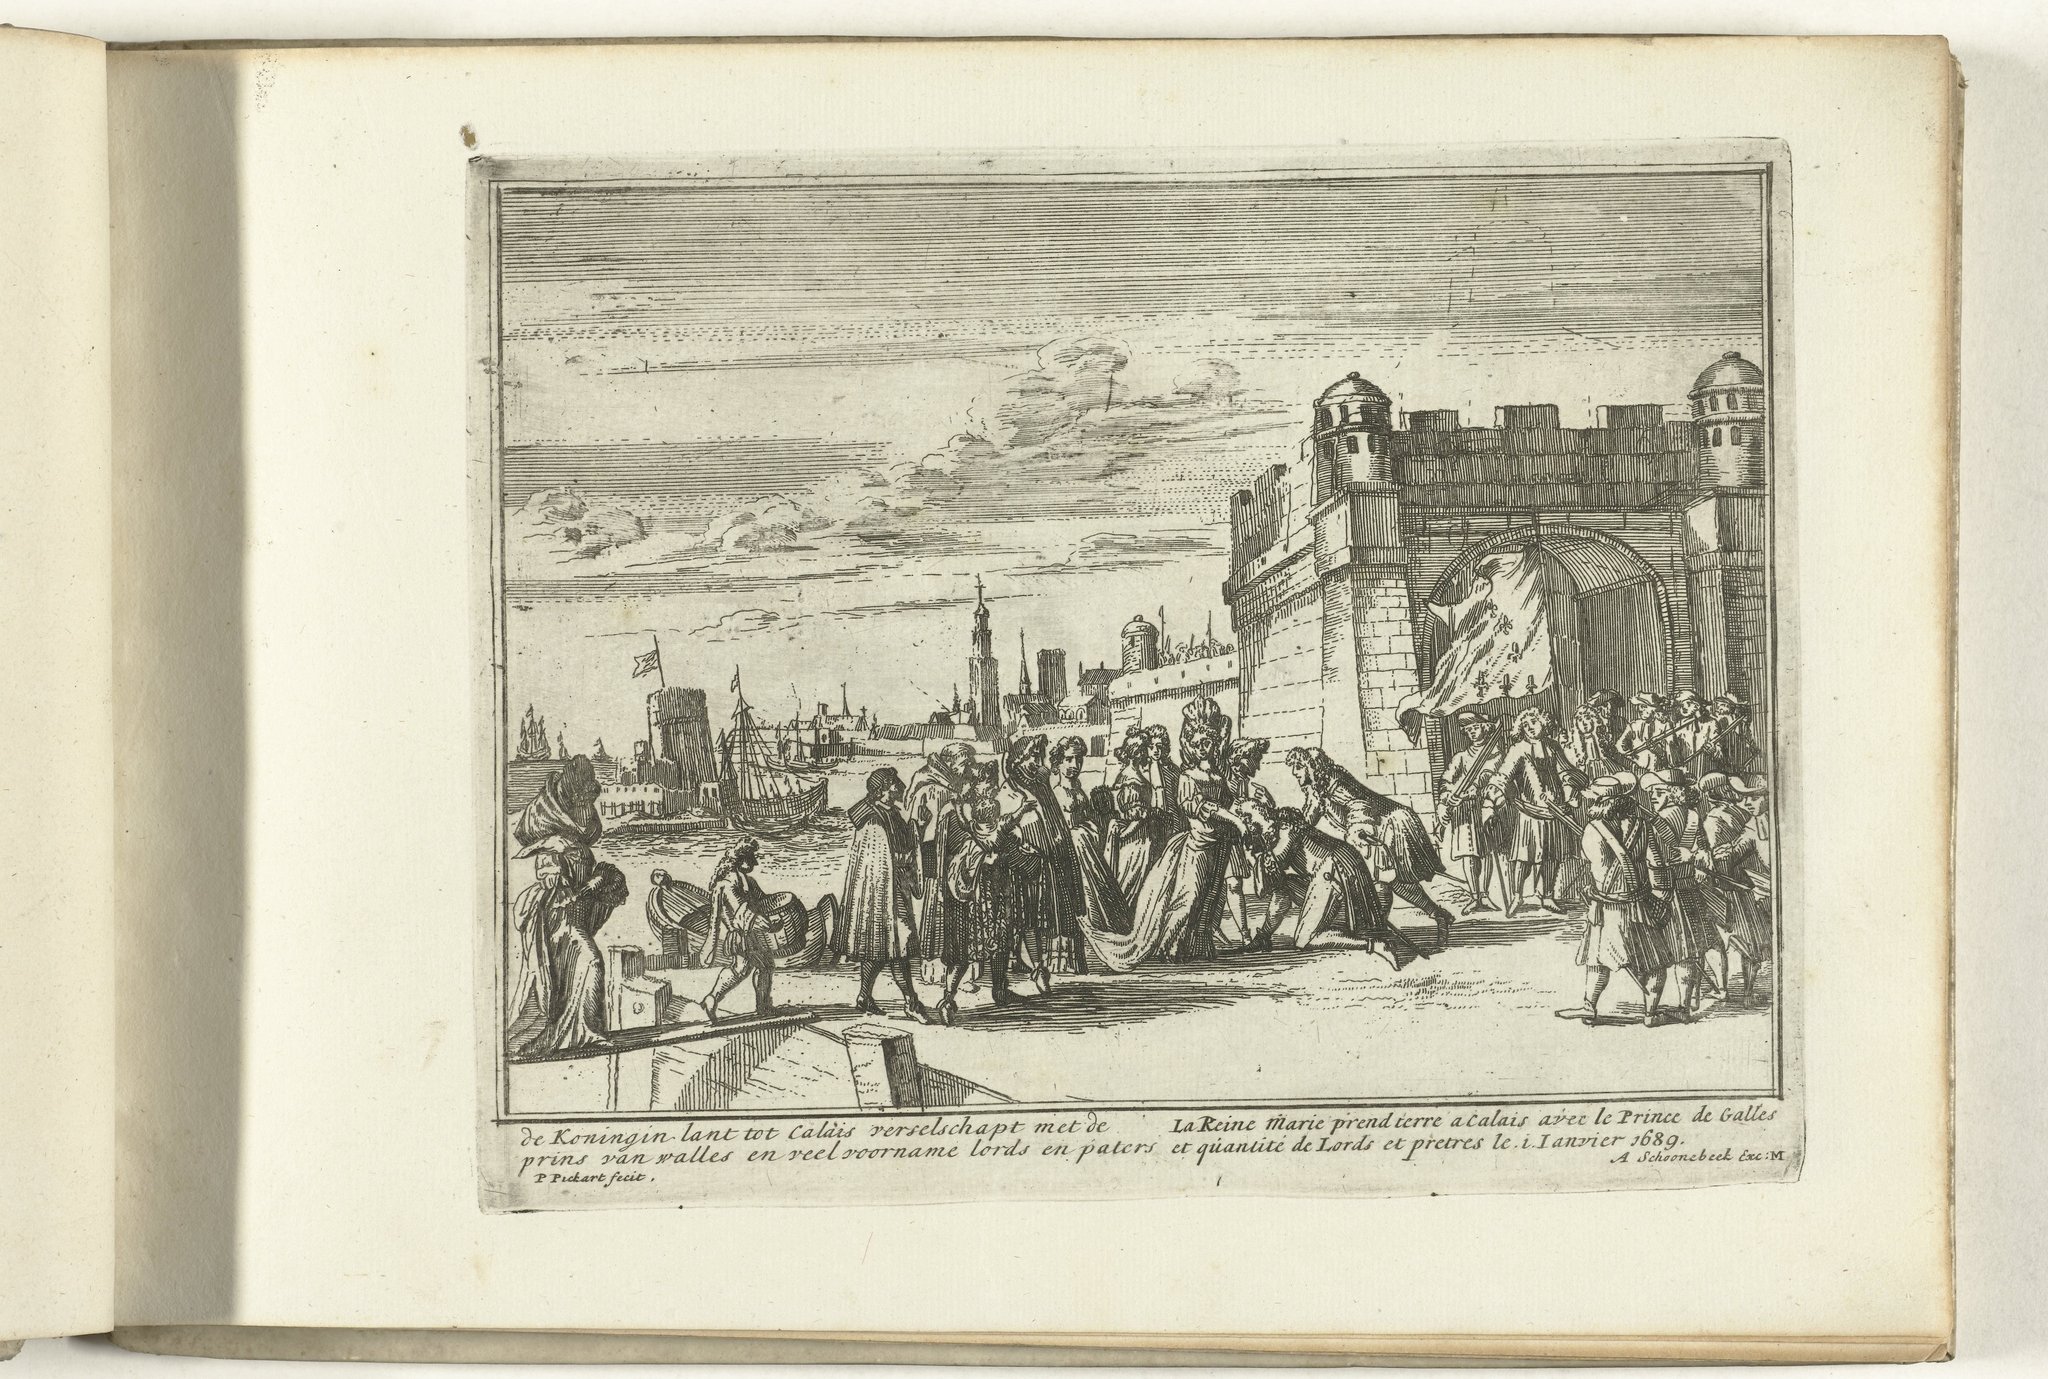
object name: print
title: de Koningin lant tot Calais verselschapt met de prins van walles en veel voorname lords en paters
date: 1689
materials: paper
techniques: etching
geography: amsterdam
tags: paris, london, flight of ruler from adversary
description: Aankomst van de gevluchte Engelse koningin Maria van Modena met de prins van Wales te Calais in Frankrijk, eind december 1688. Zij wordt op de kade ontvangen door vertegenwoordigers van de Franse koning. Plaat M in de serie 'Engelants schouwtoneel' over de Glorious Revolution en gebeurtenissen uit de voorafgaande jaren 1685-1689 (eerste deel). Met onderschriften in het Nederlands en Frans.